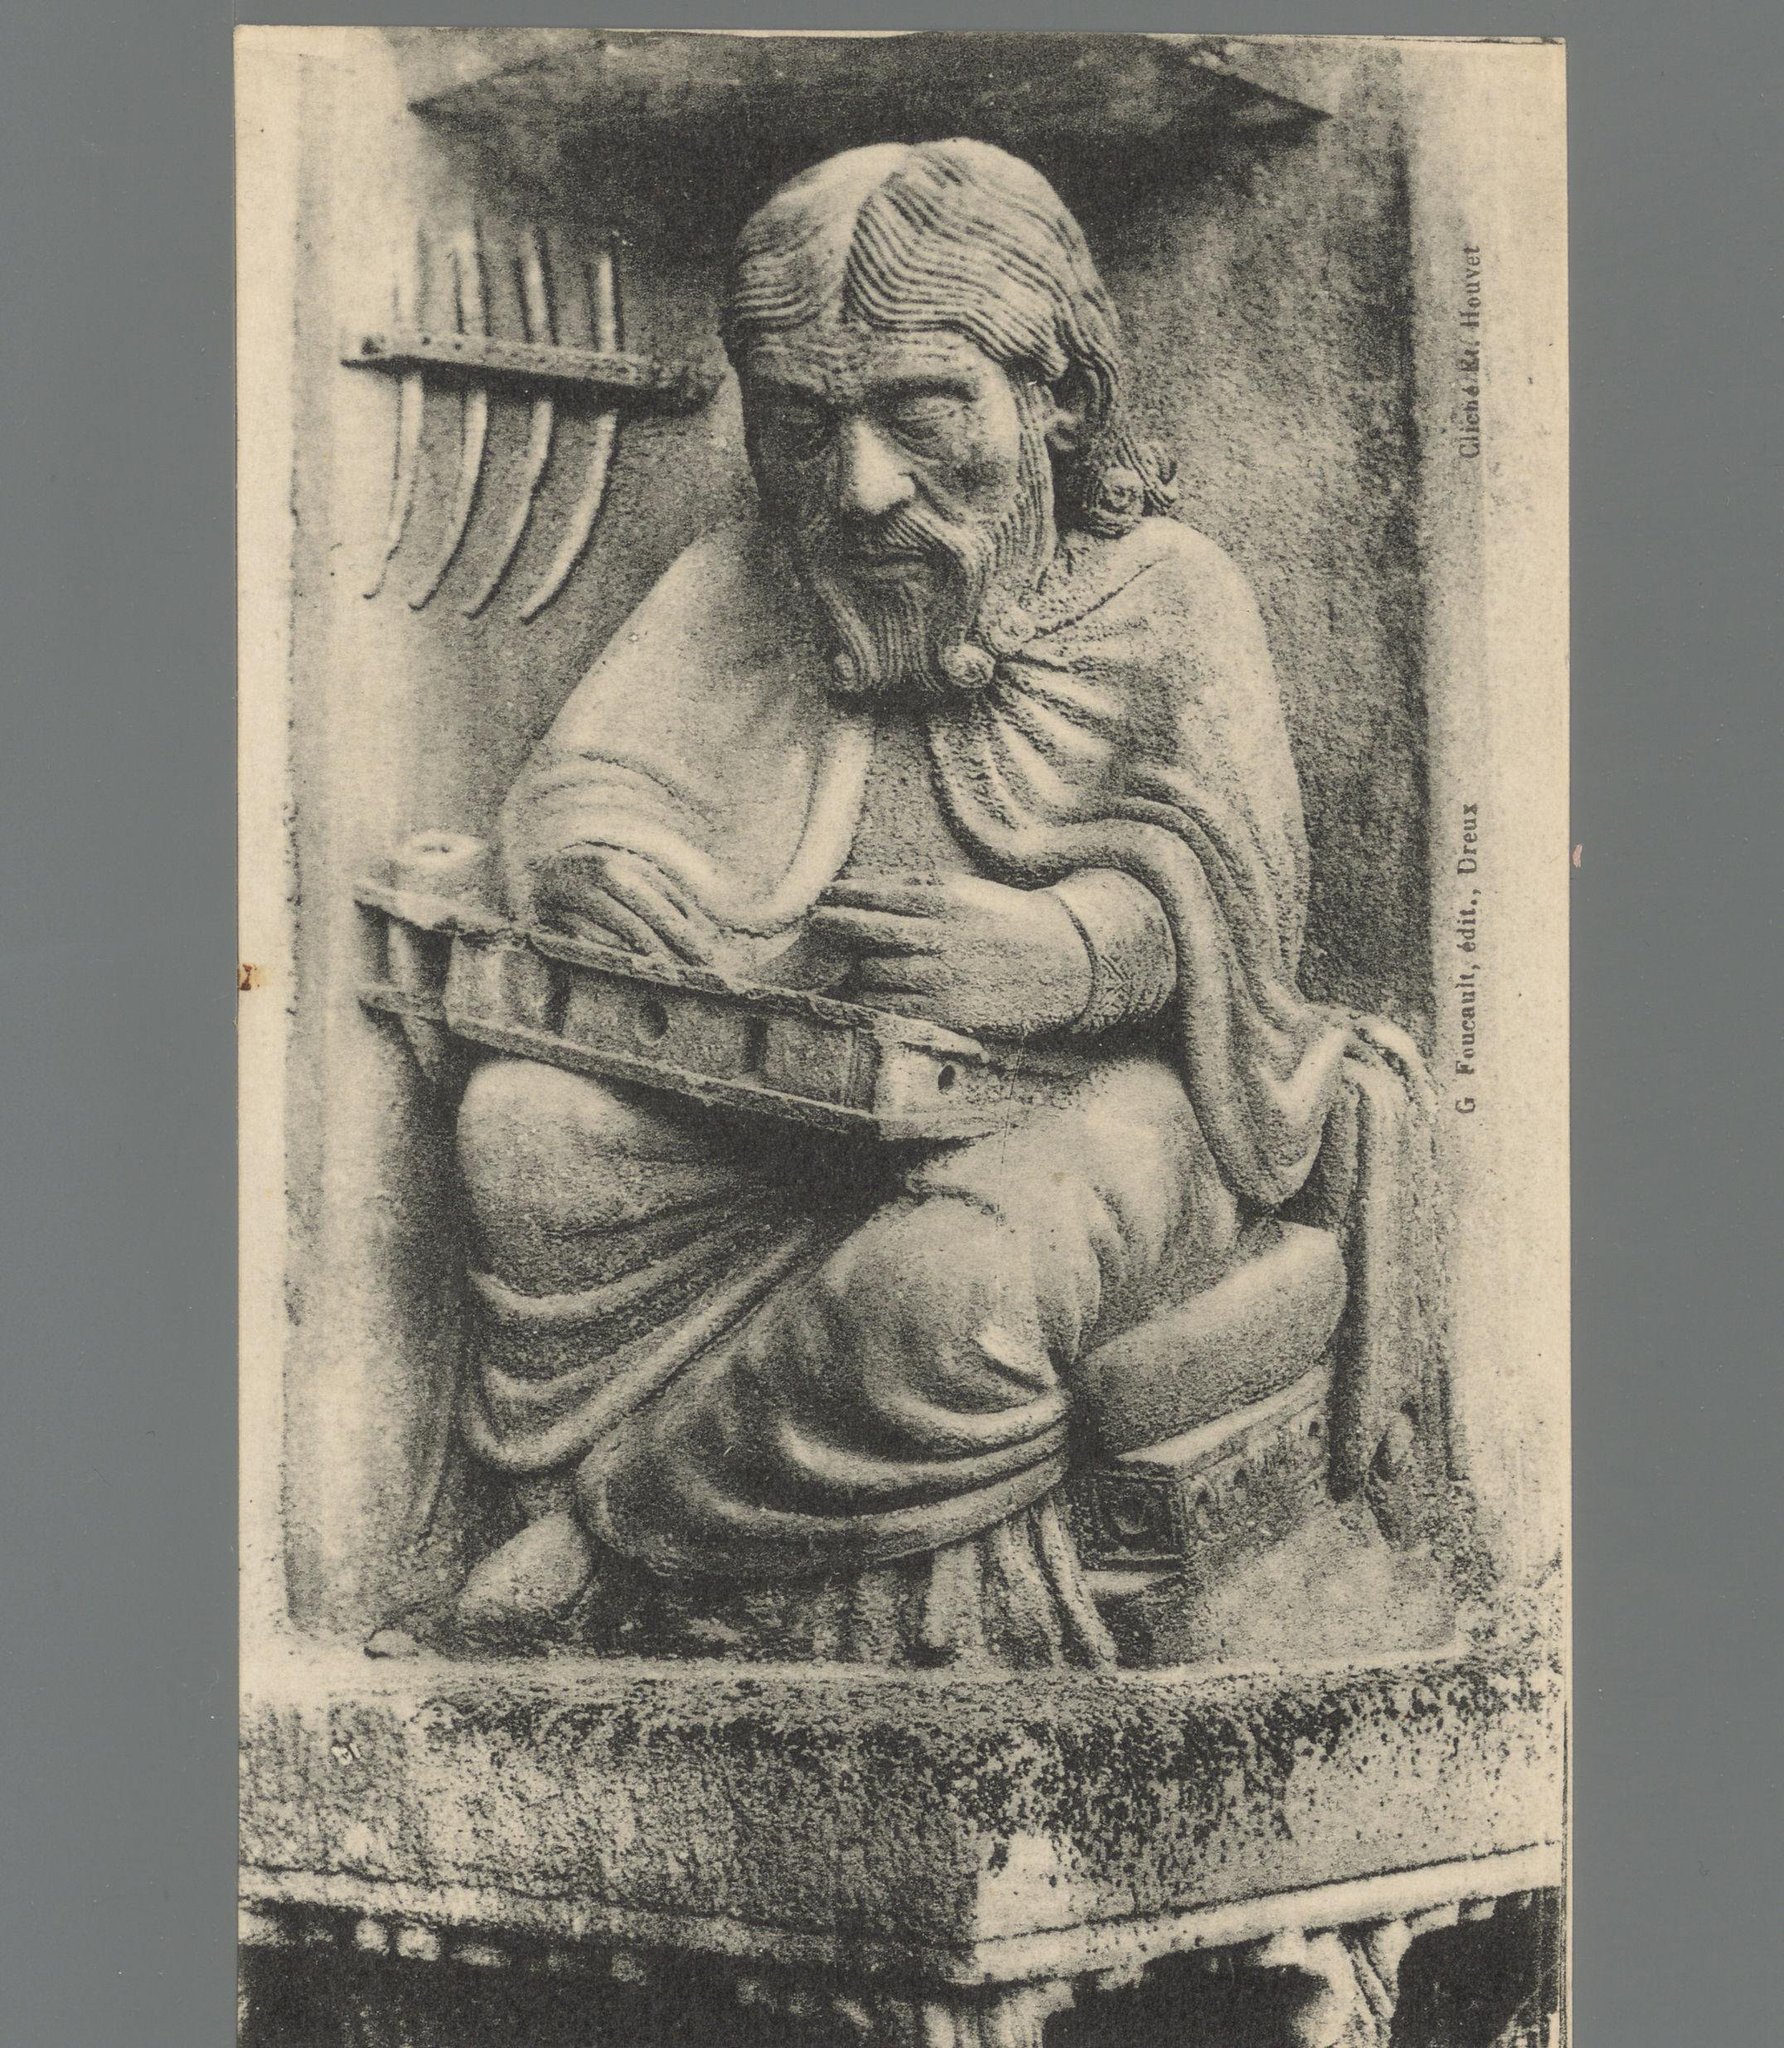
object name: photomechanical print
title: Cathédrale de Chartres (E. et L.). Détail du Portail Royal (XIIe siècle). Donat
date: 1903-1930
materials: cardboard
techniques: photograph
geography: chartres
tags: church (exterior), statues, paintings, etc. ~ objects of worship in roman religion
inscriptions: collector's mark: ‘AFE v S’